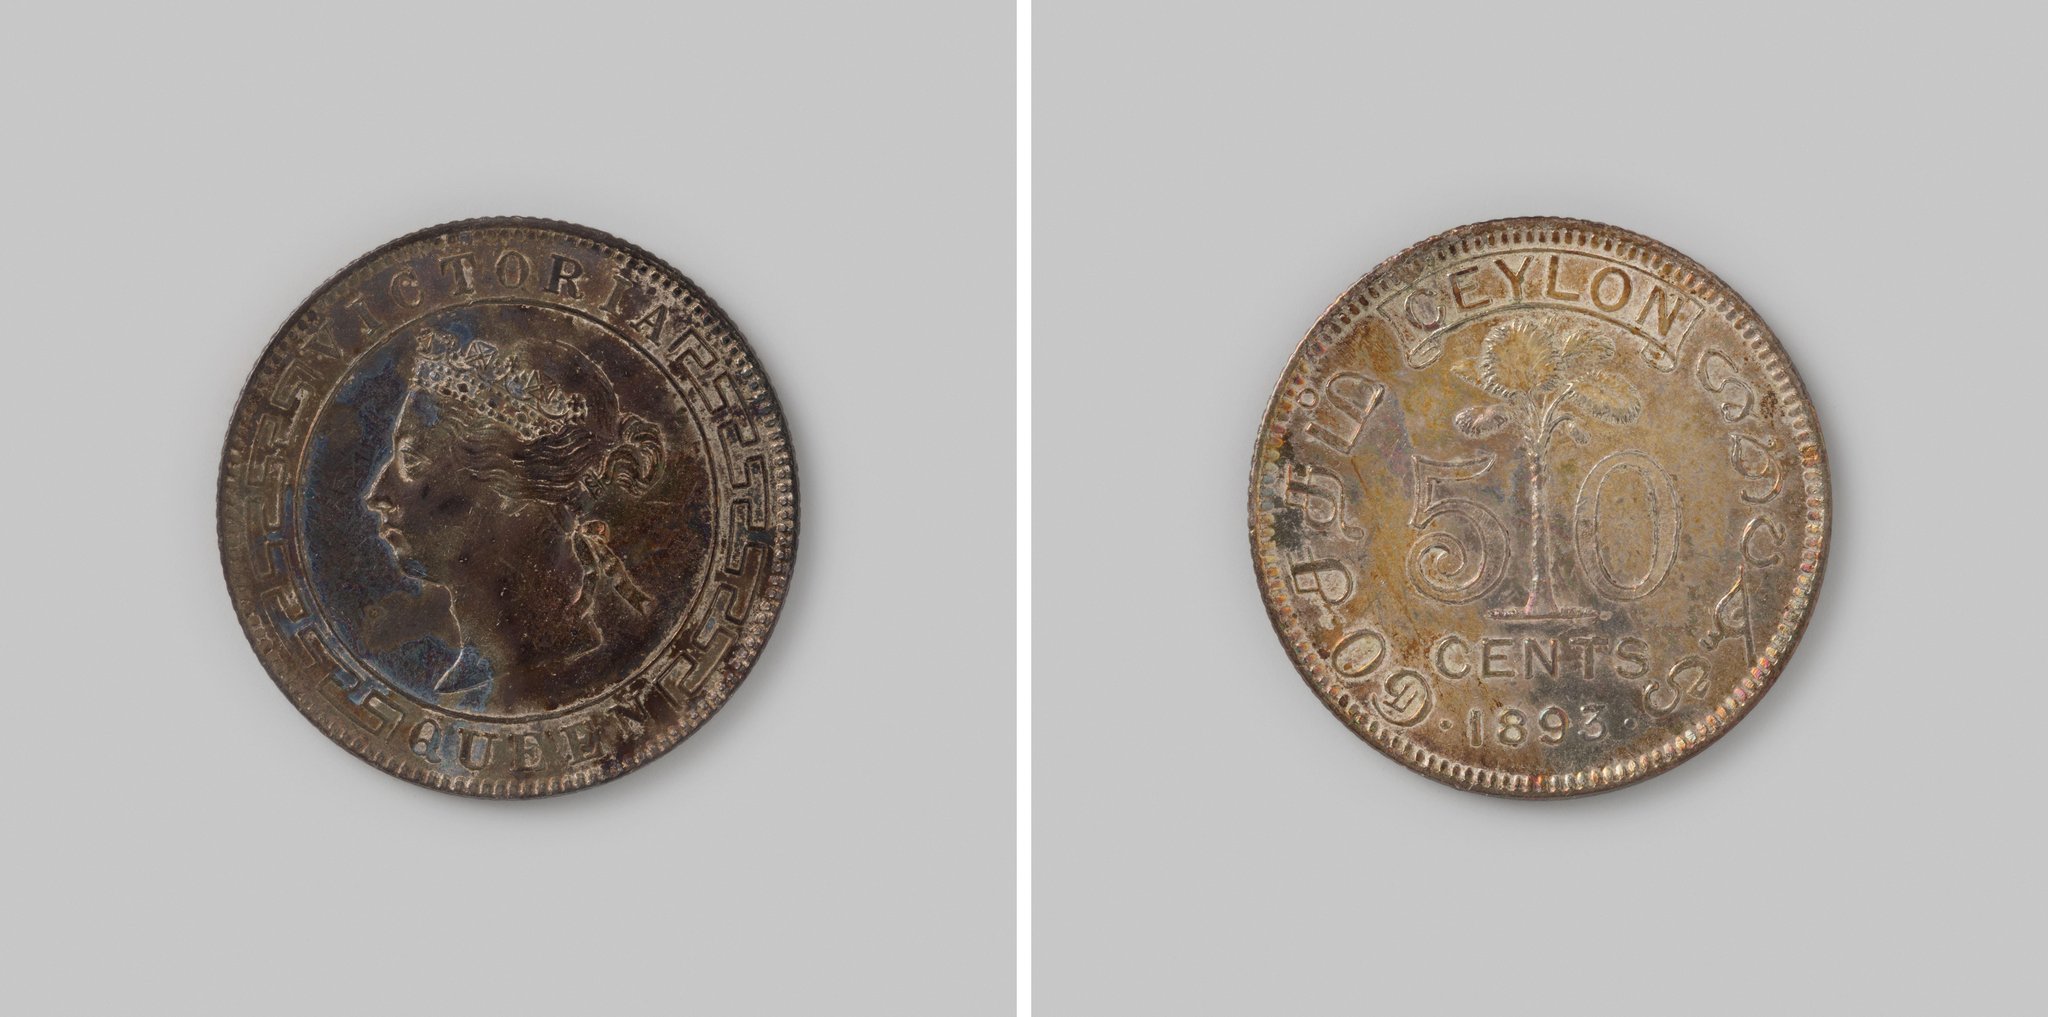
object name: coin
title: 50 cents van Sri Lanka, Ceylon op naam van koningin Victoria, 1893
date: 1893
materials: silver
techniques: striking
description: Zilveren munt. Voorzijde: hoofd met diadeem van de koningin naar links. Keerzijde: tussen waarde-aanduiding - in twee regels - palmboom. Jaartal onderaan. Kartelrand.